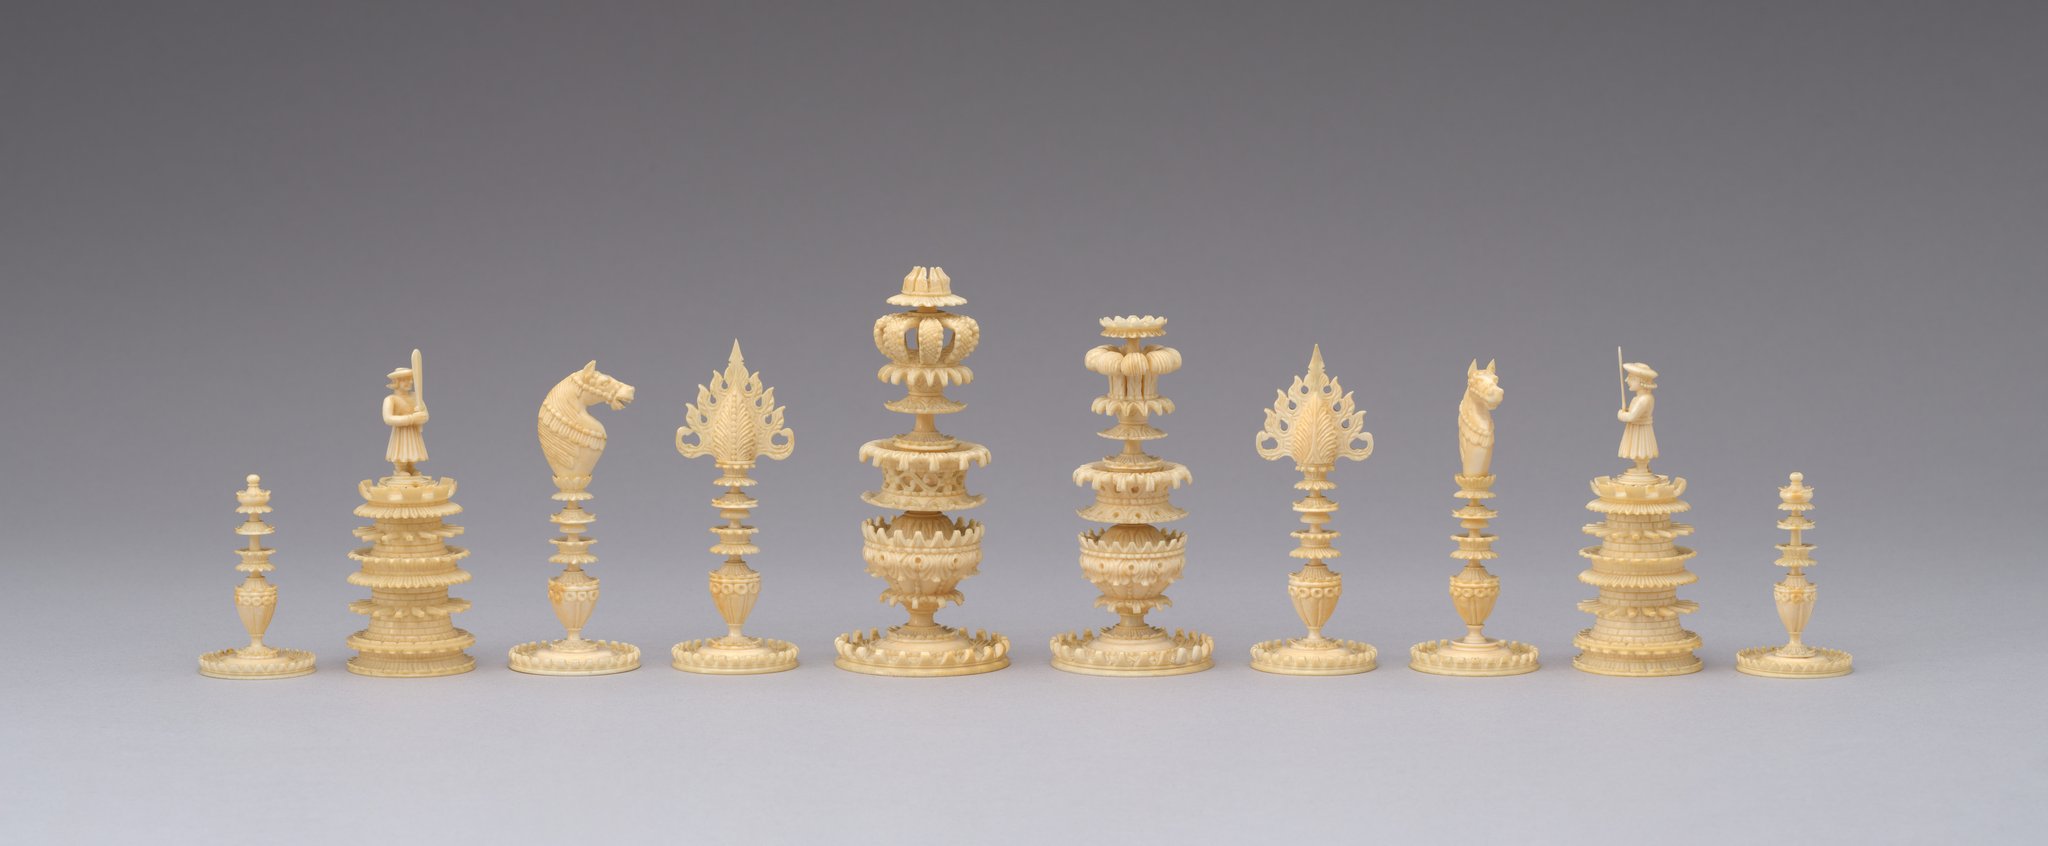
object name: chessman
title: Chessmen (32)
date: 1867-1900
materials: ivory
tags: chess,games